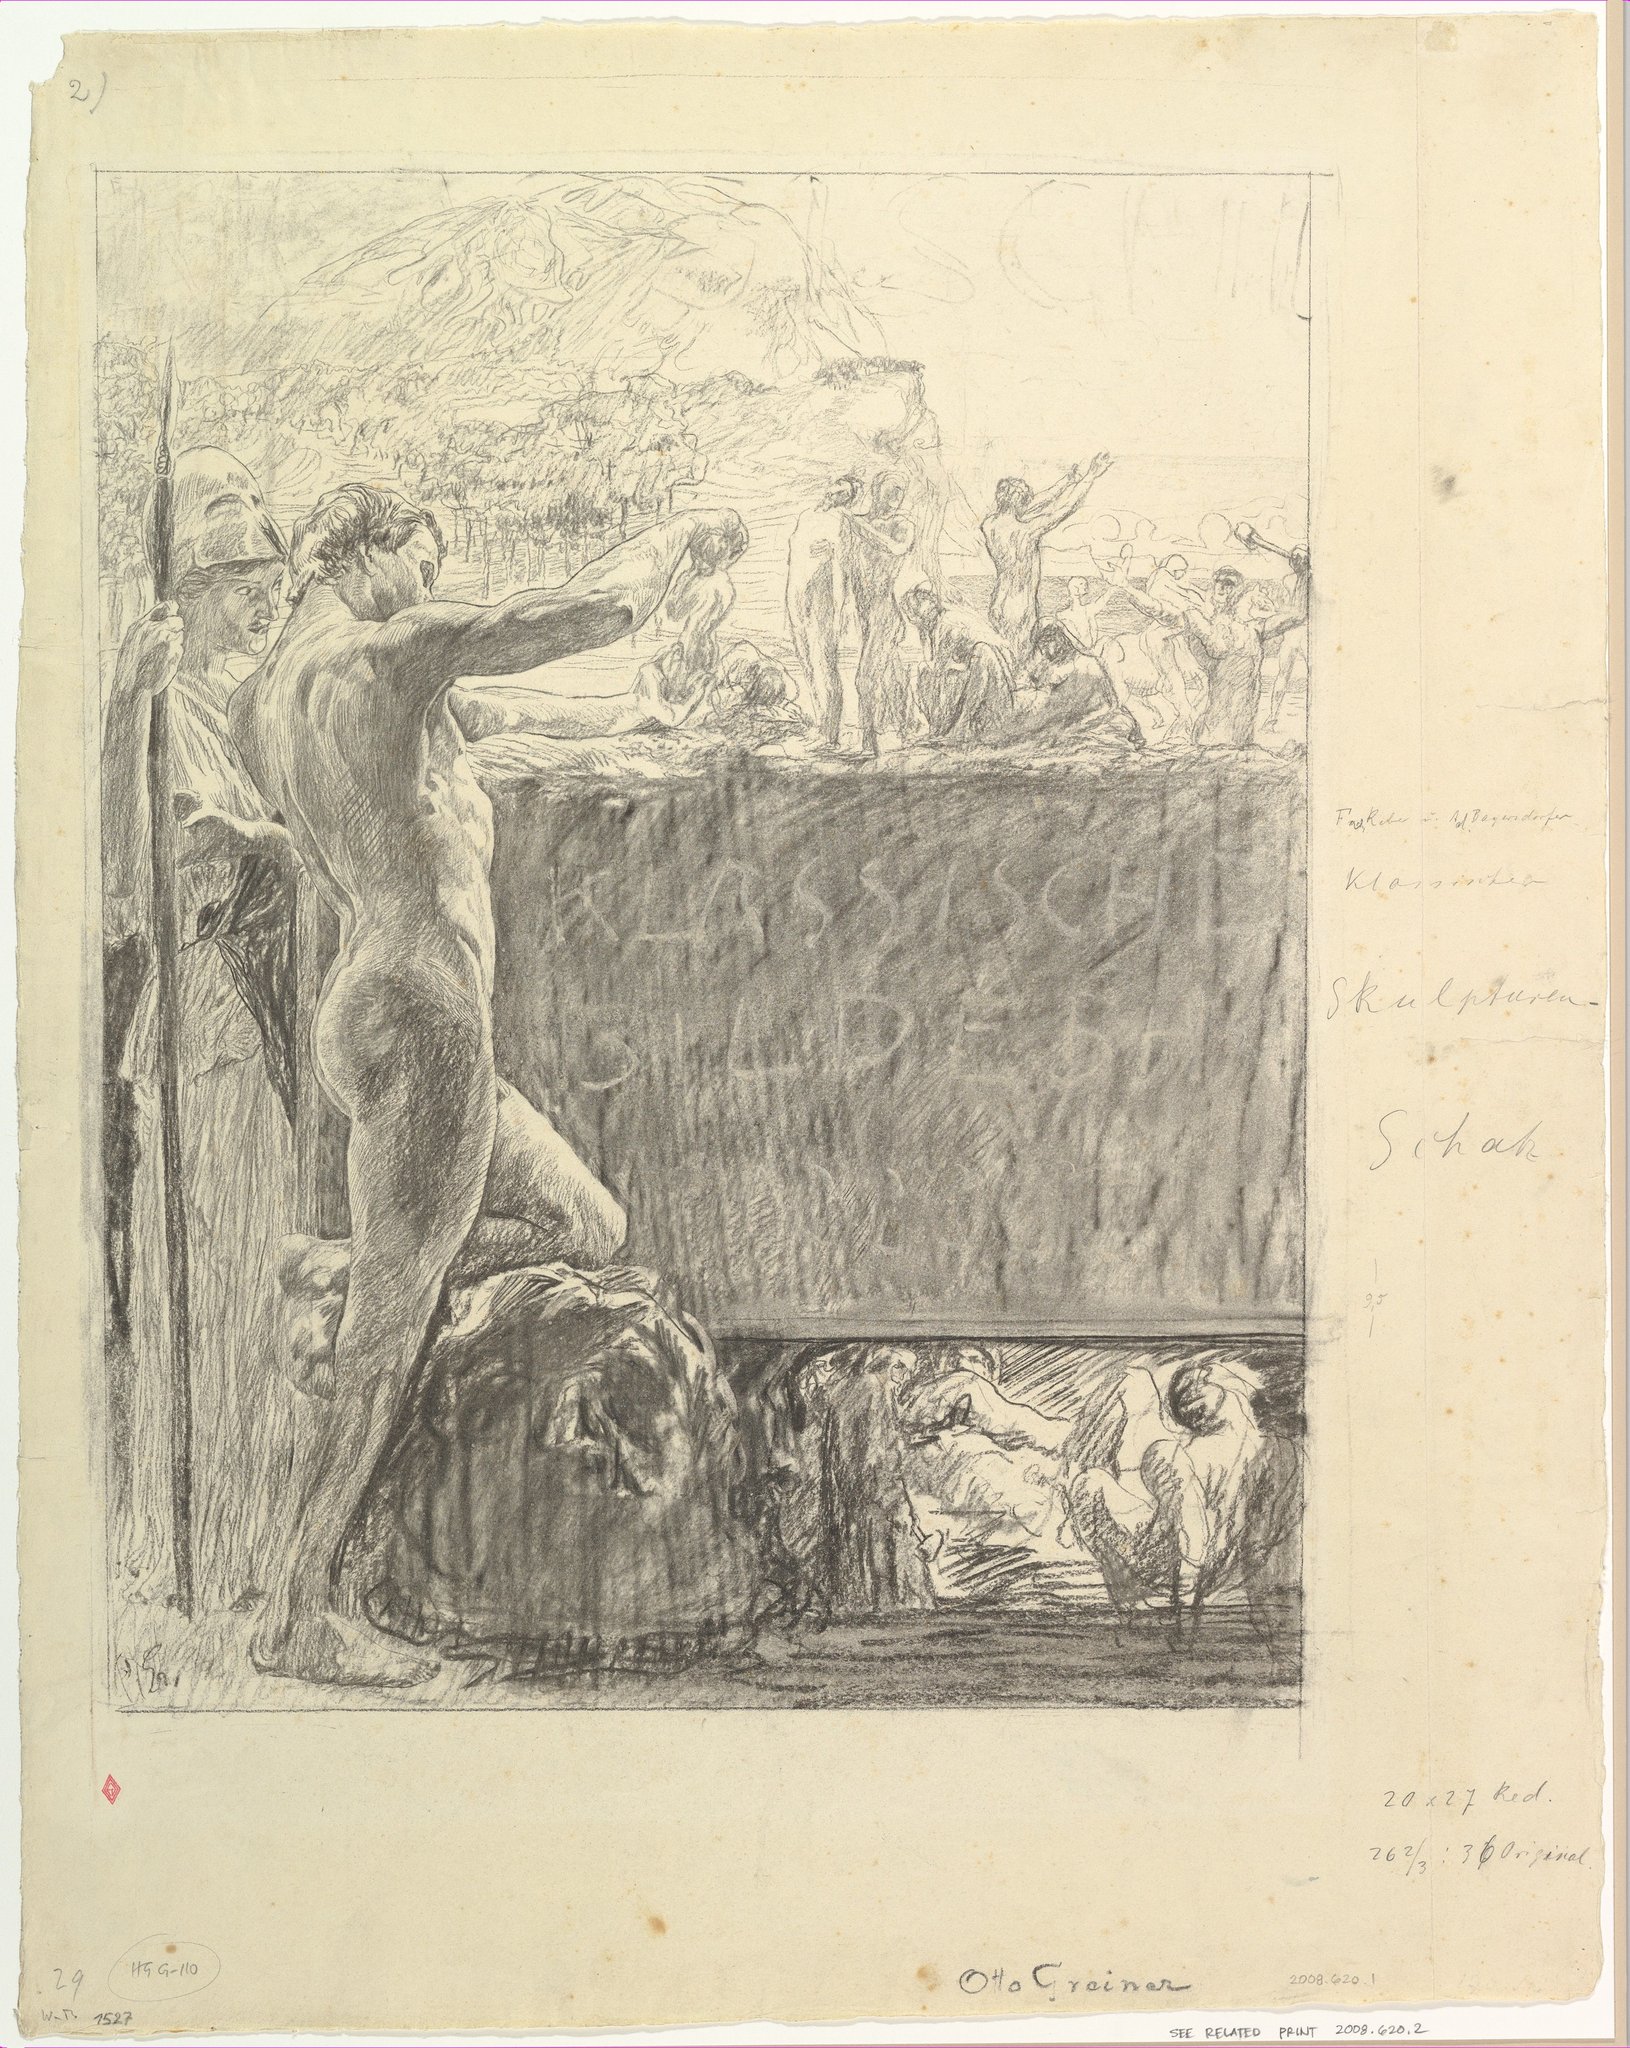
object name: drawing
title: Cover design for 'Klassischer Skulpurenschatz'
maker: otto greiner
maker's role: artist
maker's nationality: german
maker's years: 1869-1916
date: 1867-1900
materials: chalk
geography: germany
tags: male nudes